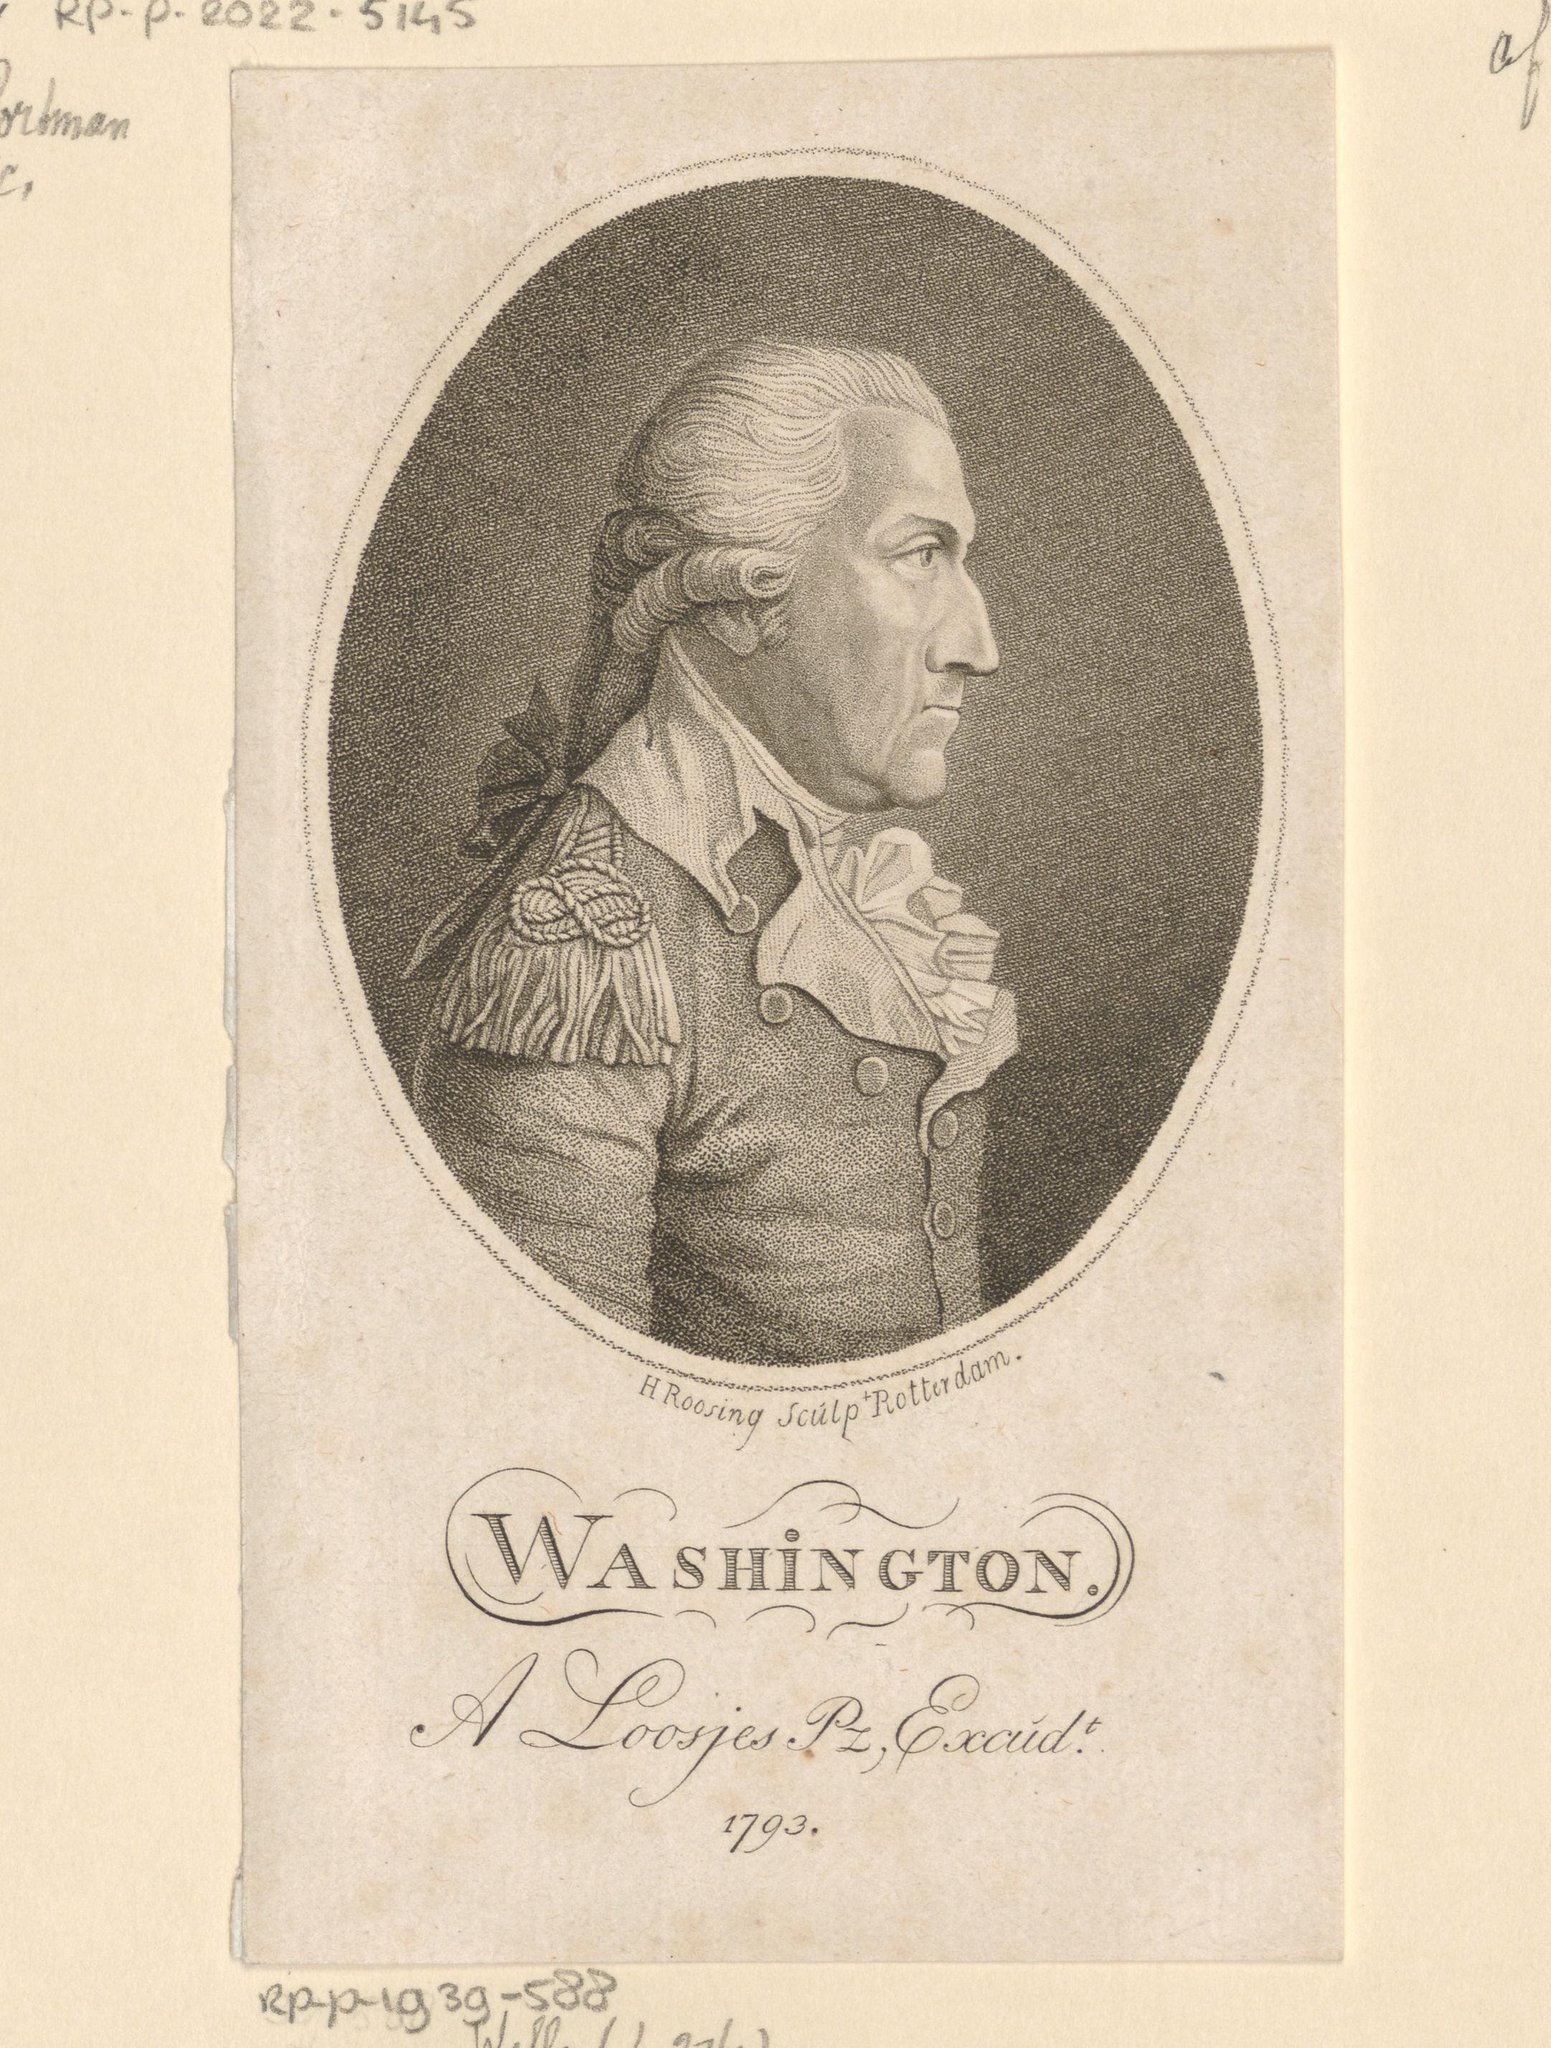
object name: print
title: Portret van George Washington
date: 1793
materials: paper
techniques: engraving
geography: haarlem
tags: president ~ head of republic, historical persons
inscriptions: collector's mark: Lugt 2166, collector's mark: Lugt 2760